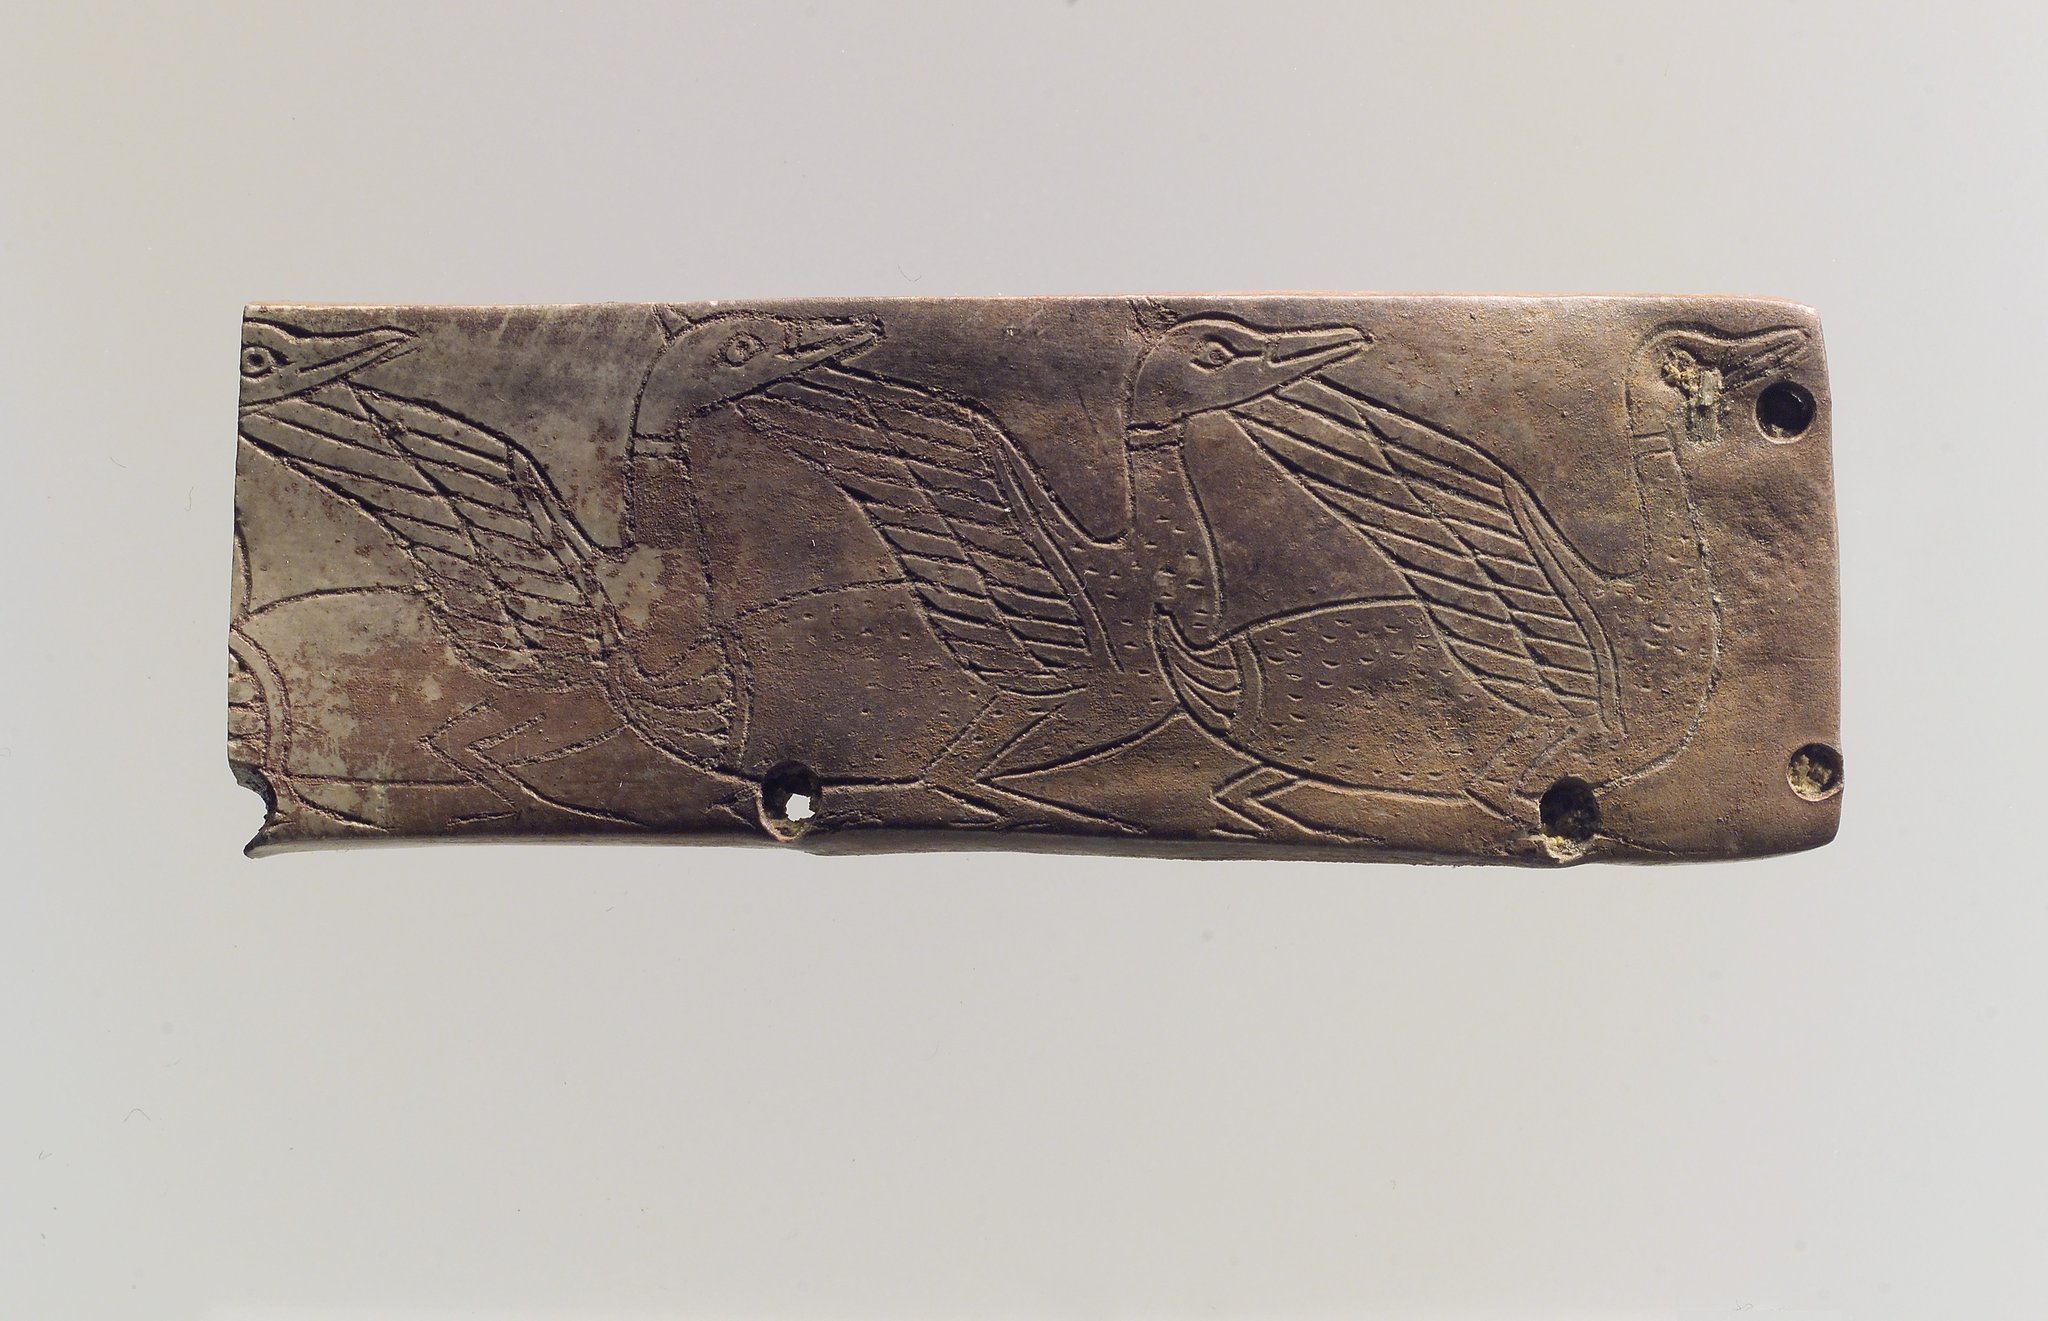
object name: furniture element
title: Furniture plaque: incised waterbirds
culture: assyrian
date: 1800-1701 BCE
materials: ivory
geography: anatolia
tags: birds